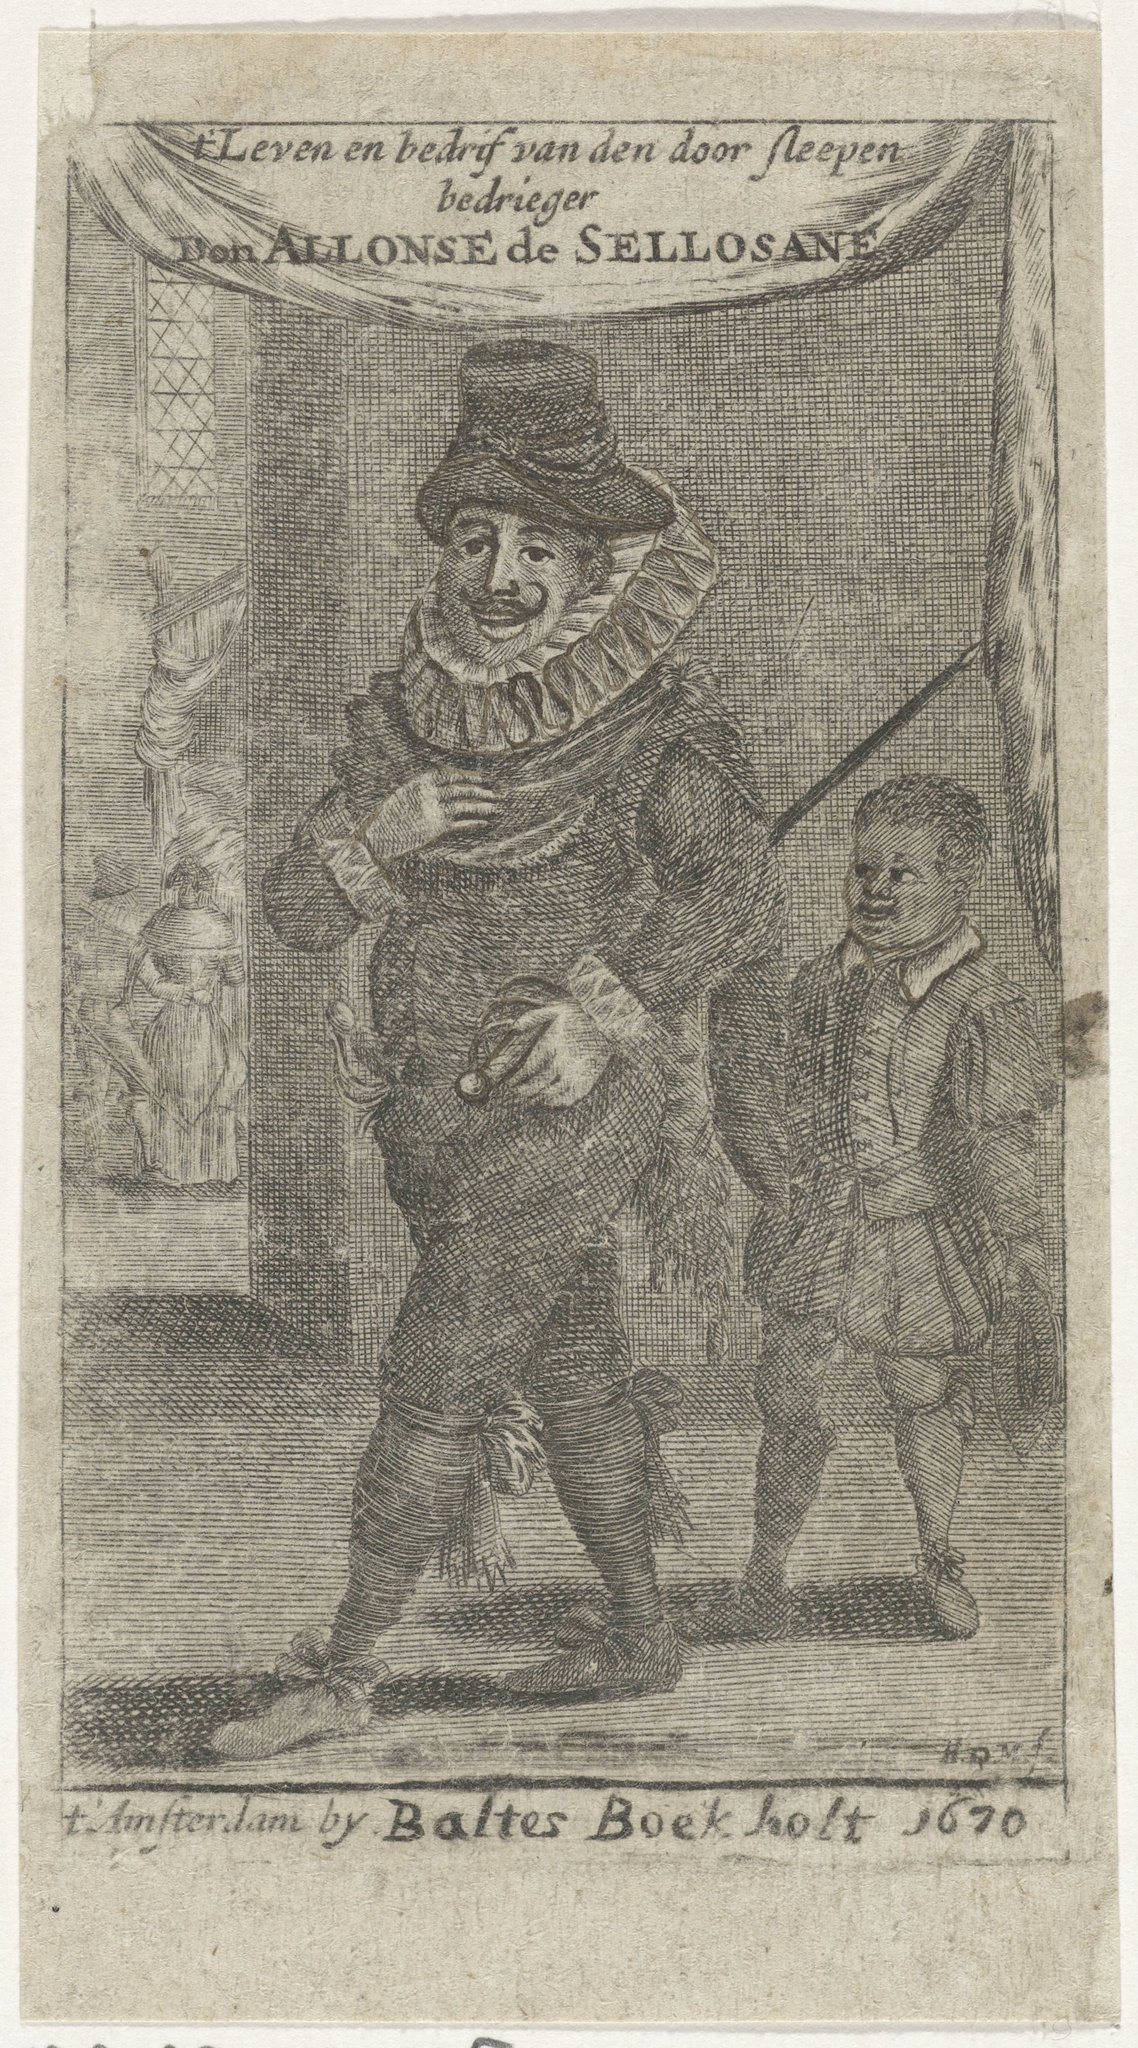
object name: print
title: Bedrieger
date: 1670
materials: paper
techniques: engraving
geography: amsterdam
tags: guile, artfulness, craftiness, deceitfulness, africans, adult man, cheat, deceit; 'fraude', 'inganno' (ripa)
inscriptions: collector's mark: Lugt 2228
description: De bedrieger, met een hoed op het hoofd, loopt met een sabel onder de arm. Achter hem staat een zwarte jongen. Linksachter staan een man en een vrouw.